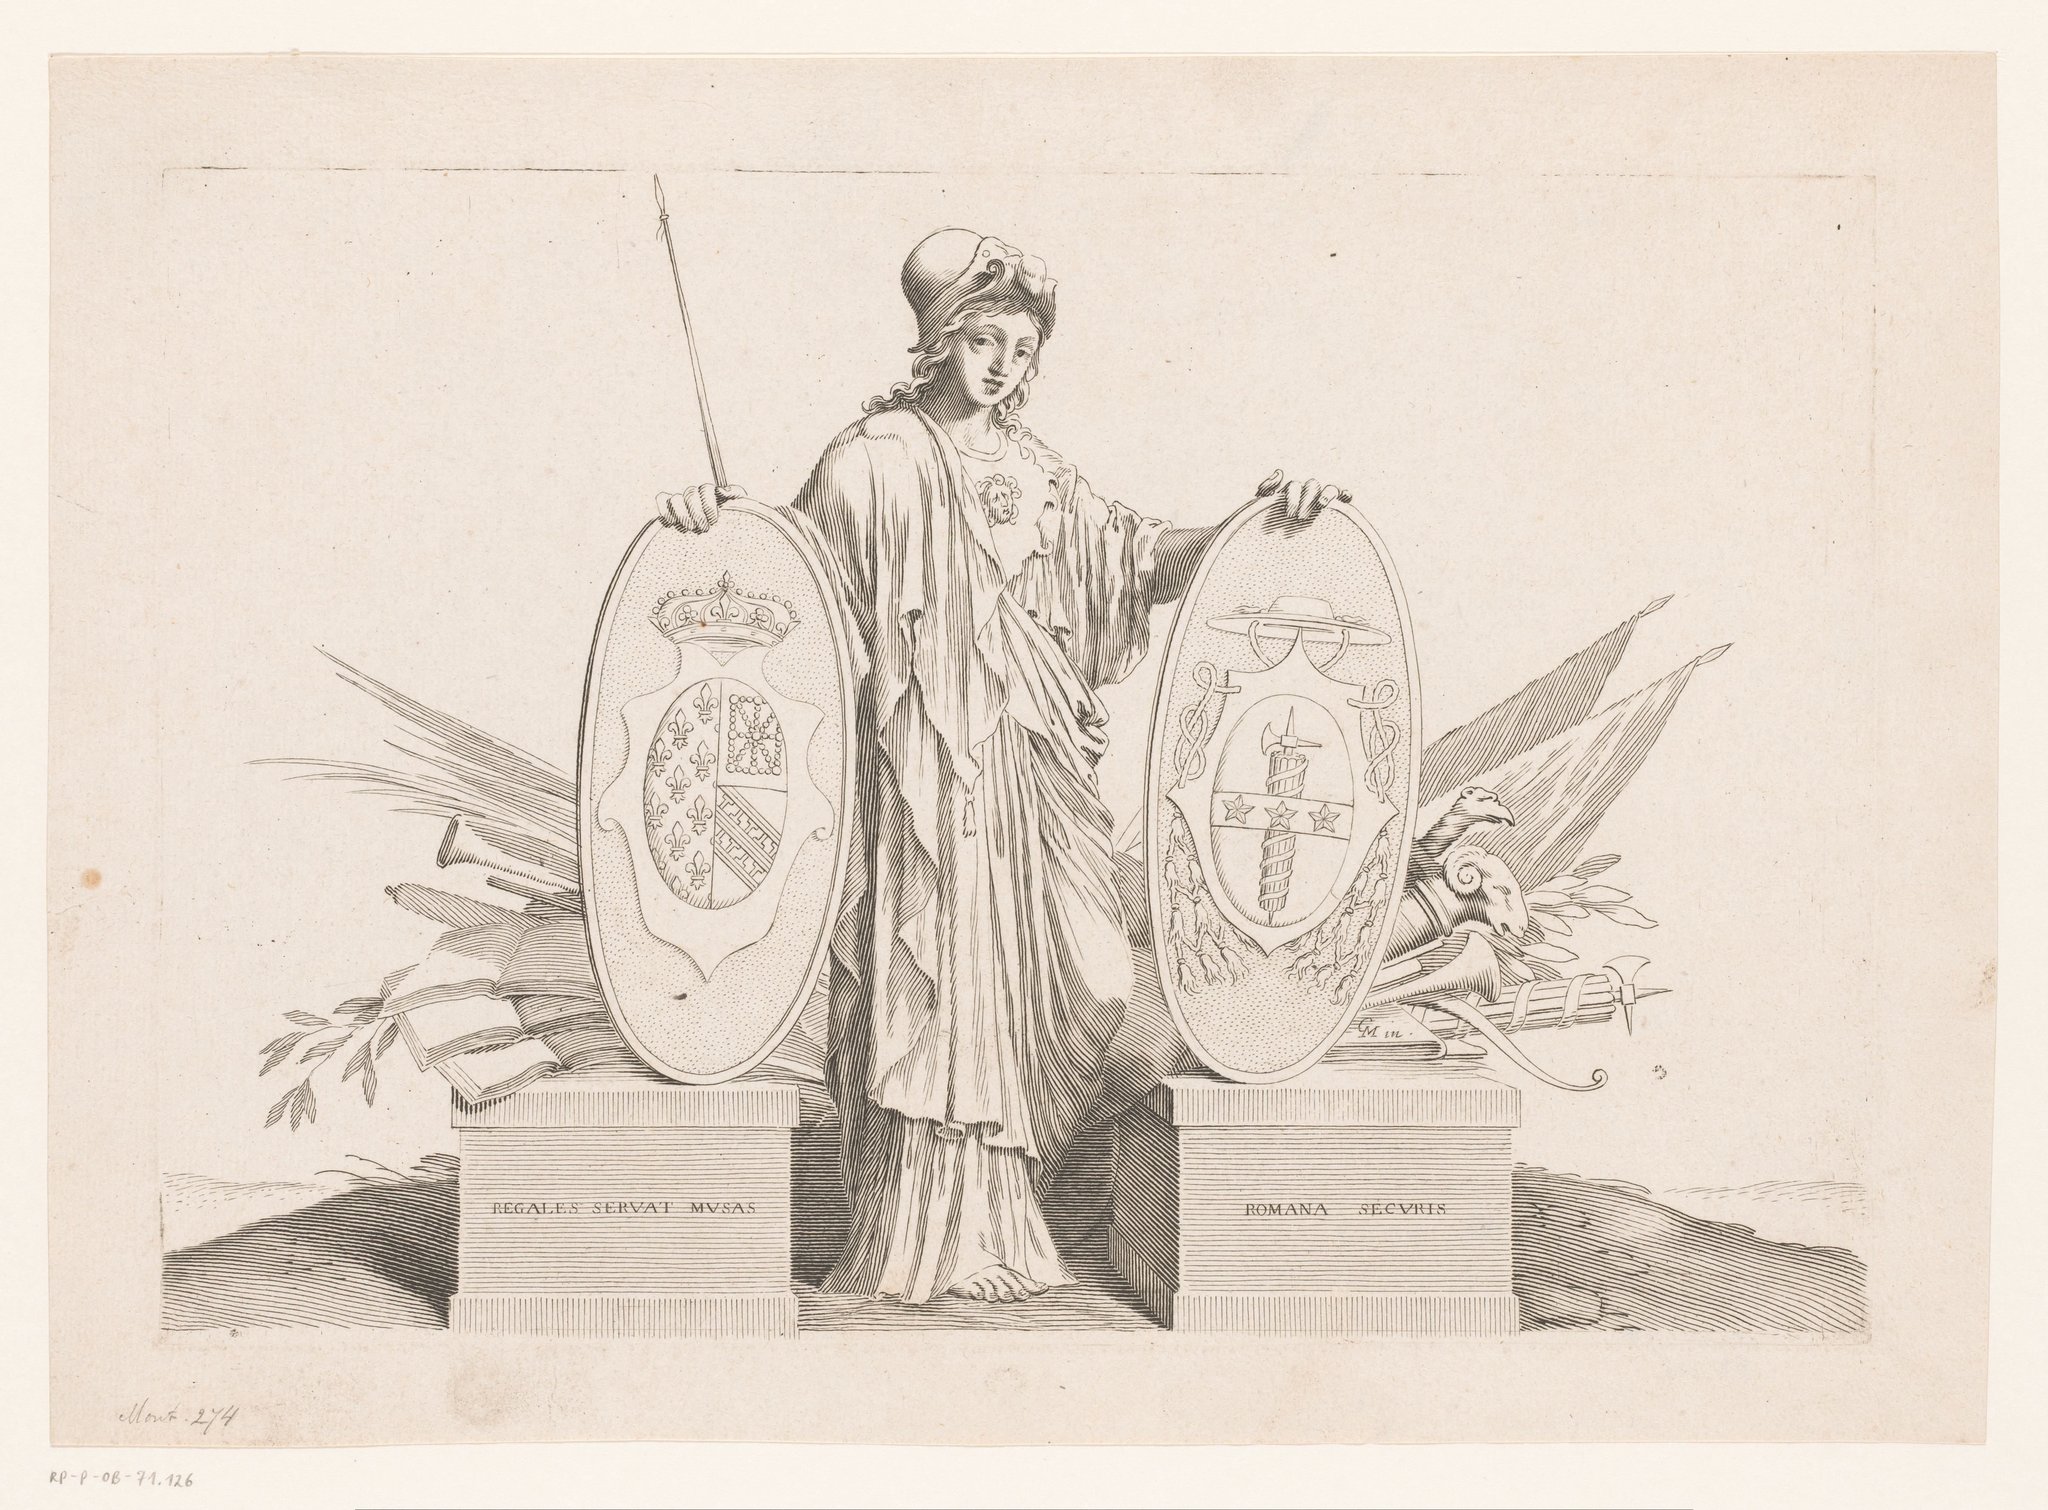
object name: print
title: Minerva met twee wapenschilden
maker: claude mellan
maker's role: draughtsman, print maker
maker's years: 1598-1688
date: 1608-1688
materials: paper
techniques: engraving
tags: (story of) minerva (pallas, athena), armorial bearing, heraldry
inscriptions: collector's mark: Lugt 240